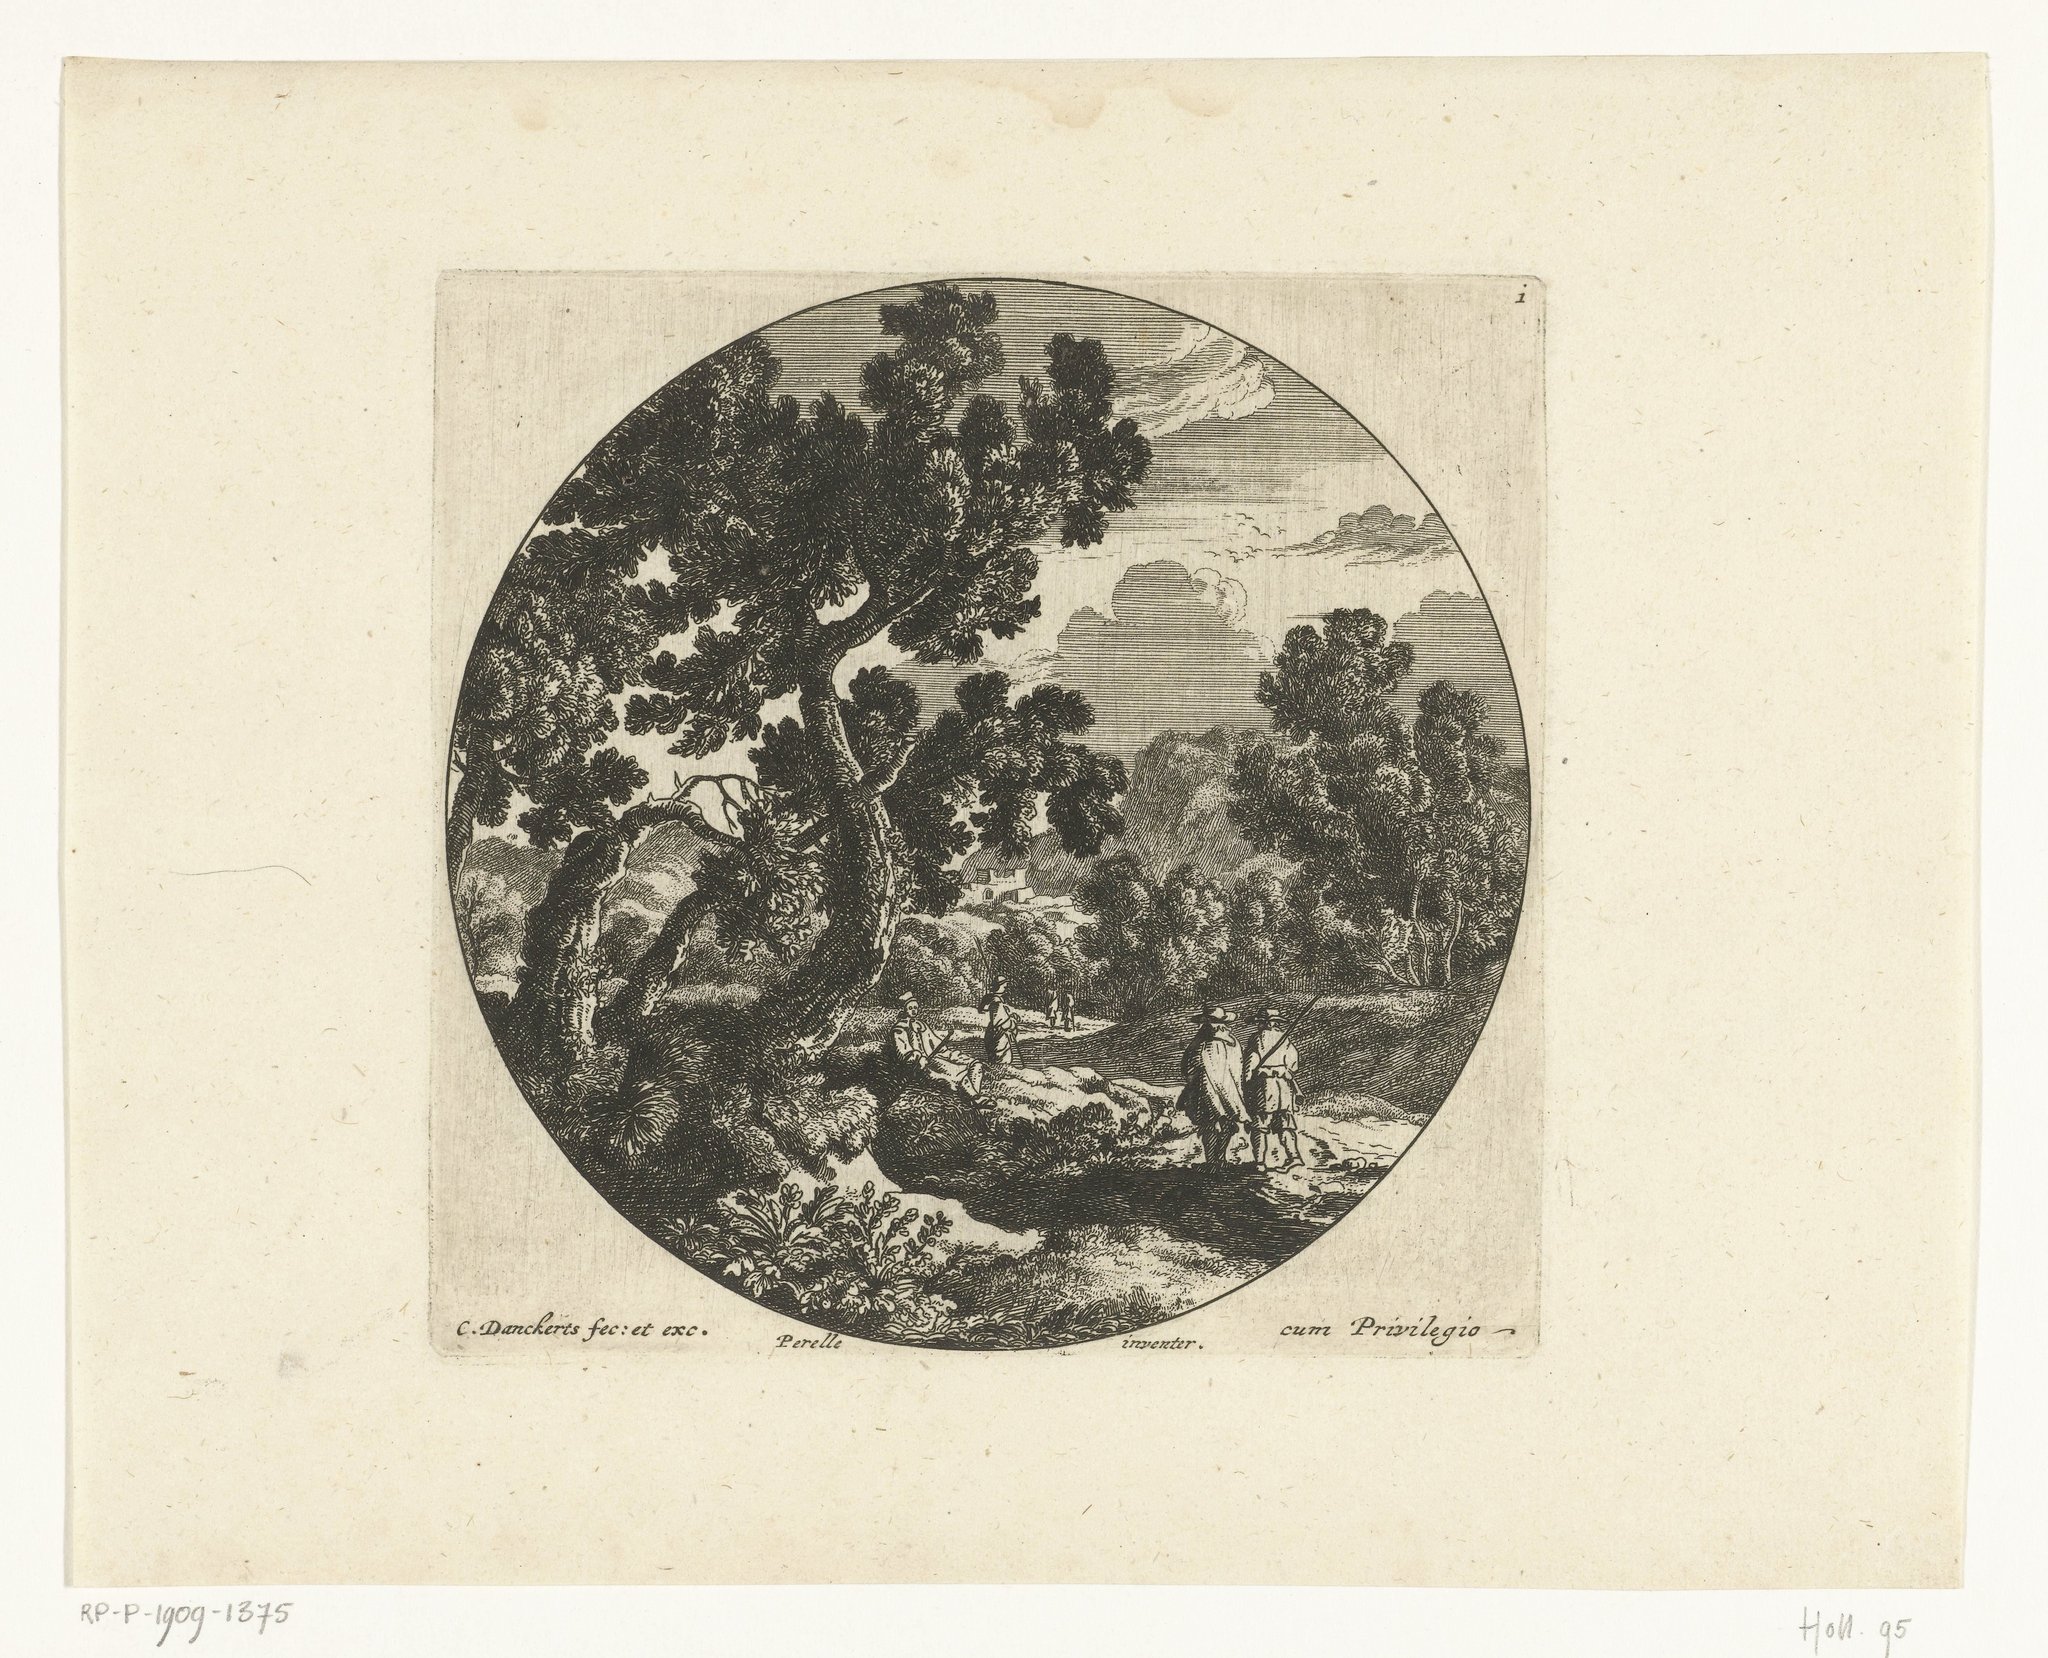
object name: print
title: Landschappen met rond kader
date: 1613-1656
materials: paper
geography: netherlands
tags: landscapes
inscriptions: collector's mark: Lugt 2228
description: Prent uit serie van zes prenten met Landschappen in rond kader naar Perelle.